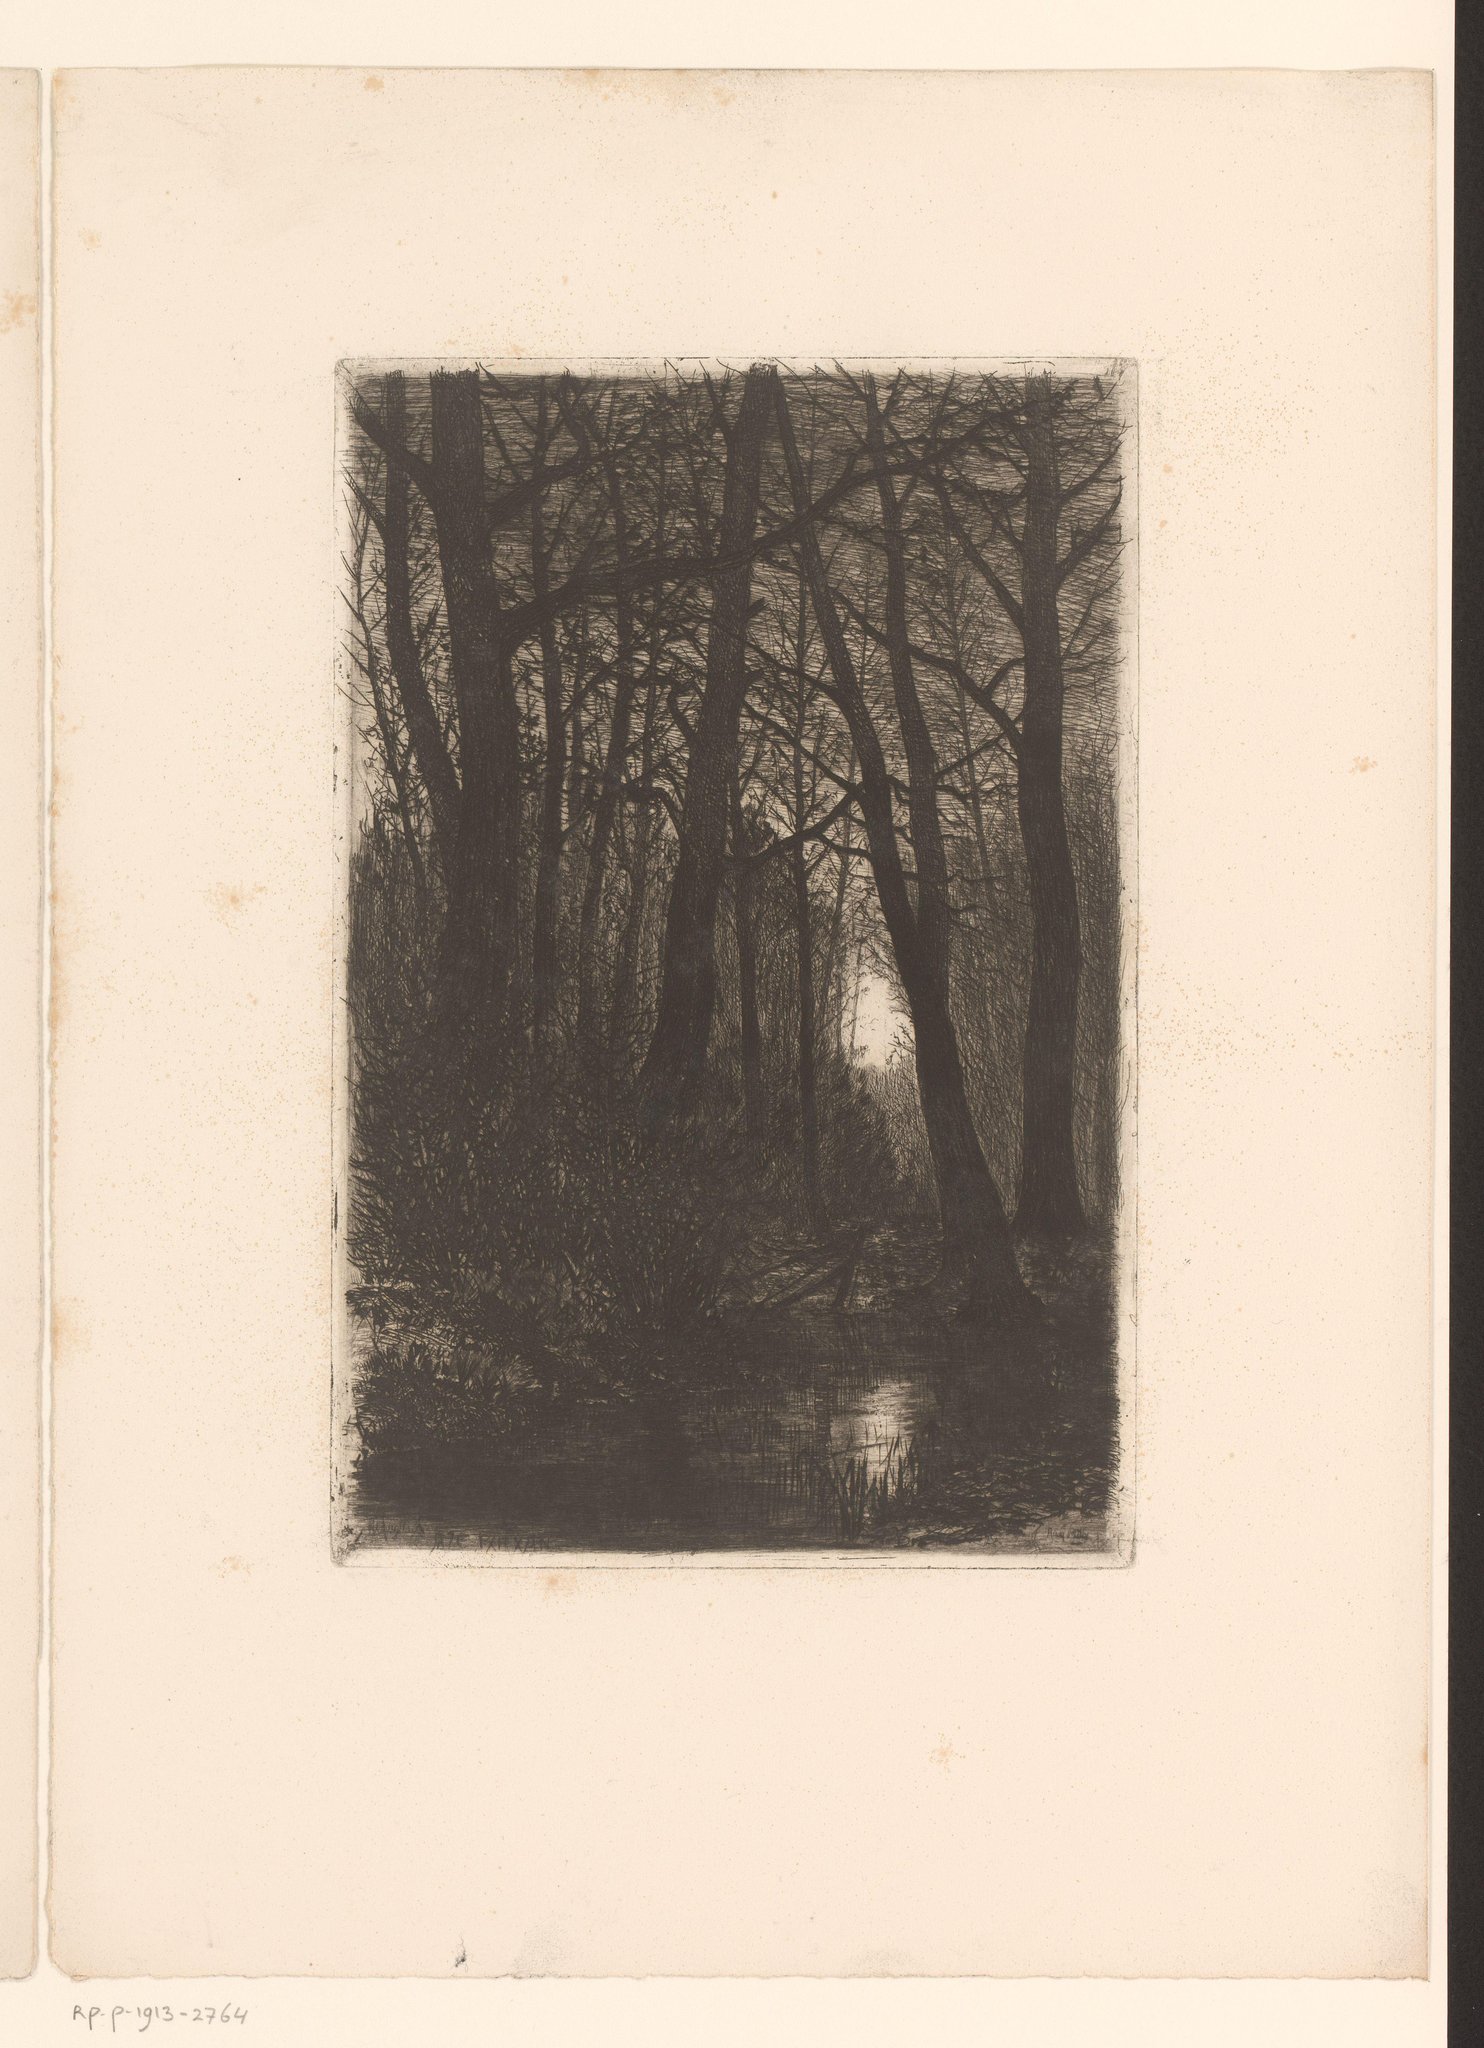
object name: print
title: Bos met sloot bij maanlicht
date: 1884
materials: paper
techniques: etching, intaglio, retroussage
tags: moonlight, forest, wood, brook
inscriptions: mark: ‘Aan Milly’, collector's mark: Lugt 2228